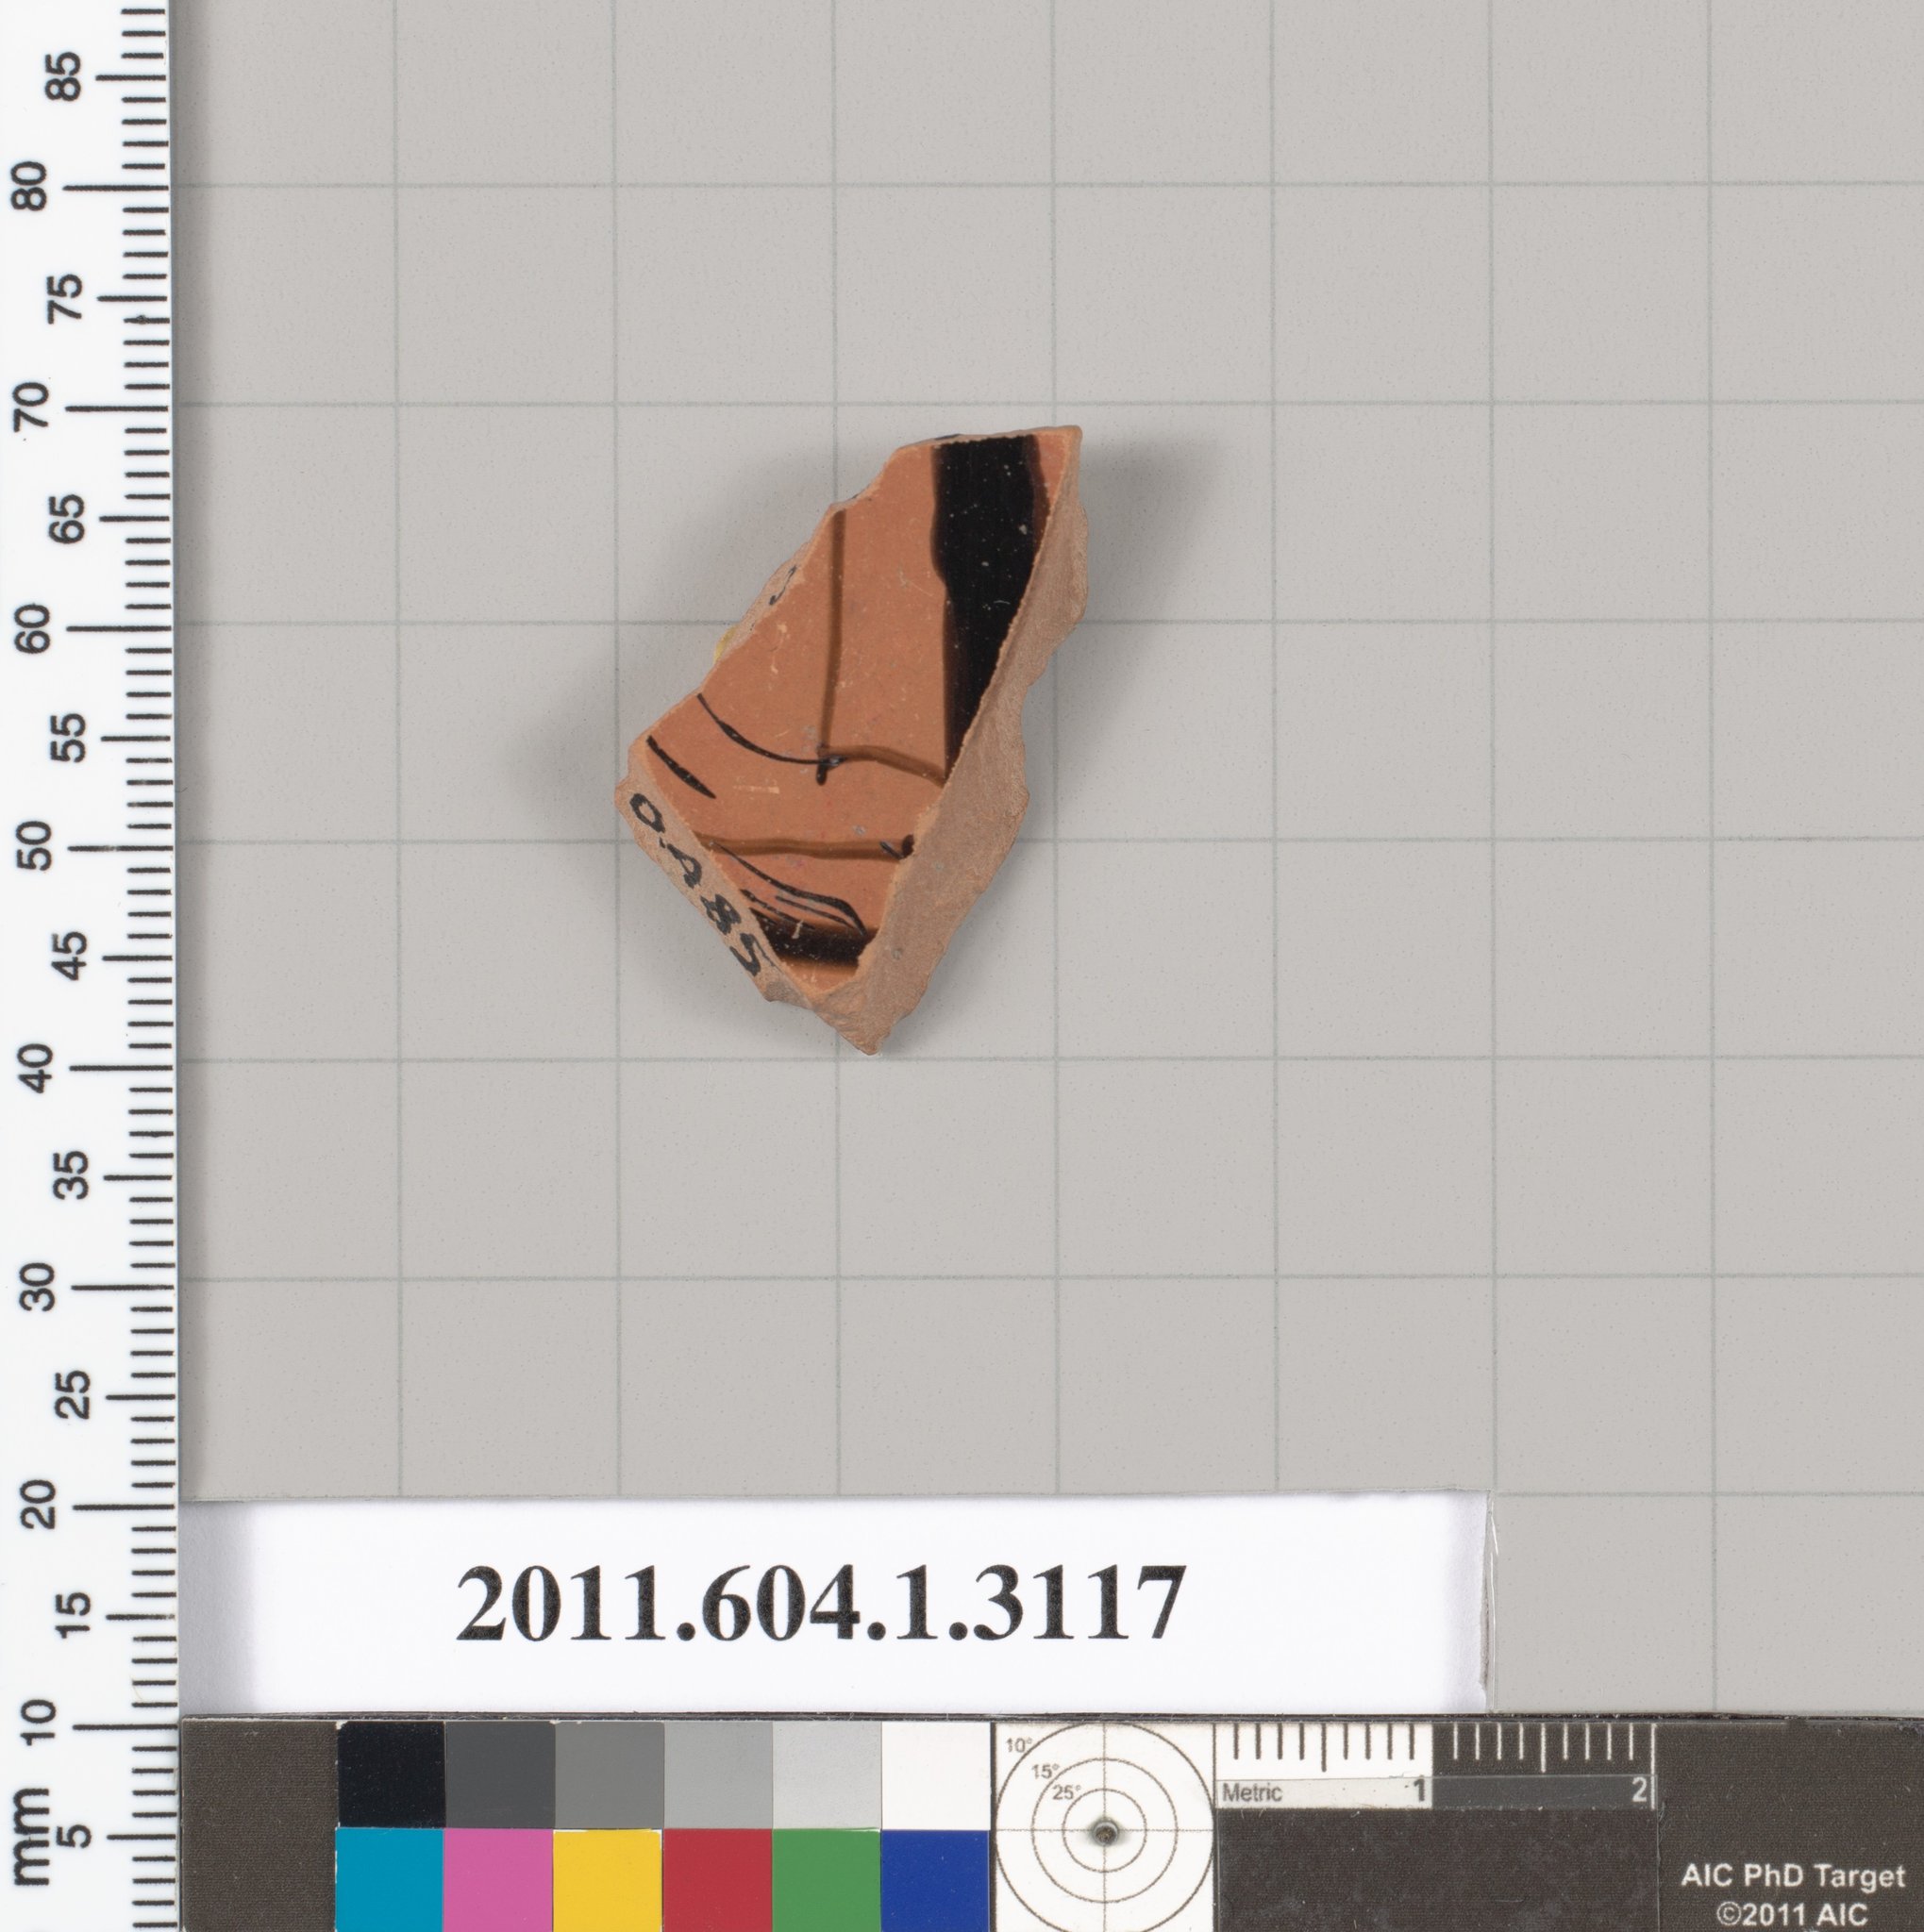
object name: kylix fragment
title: Terracotta fragment of a kylix (drinking cup)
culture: greek, attic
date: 475-451 BCE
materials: terracotta